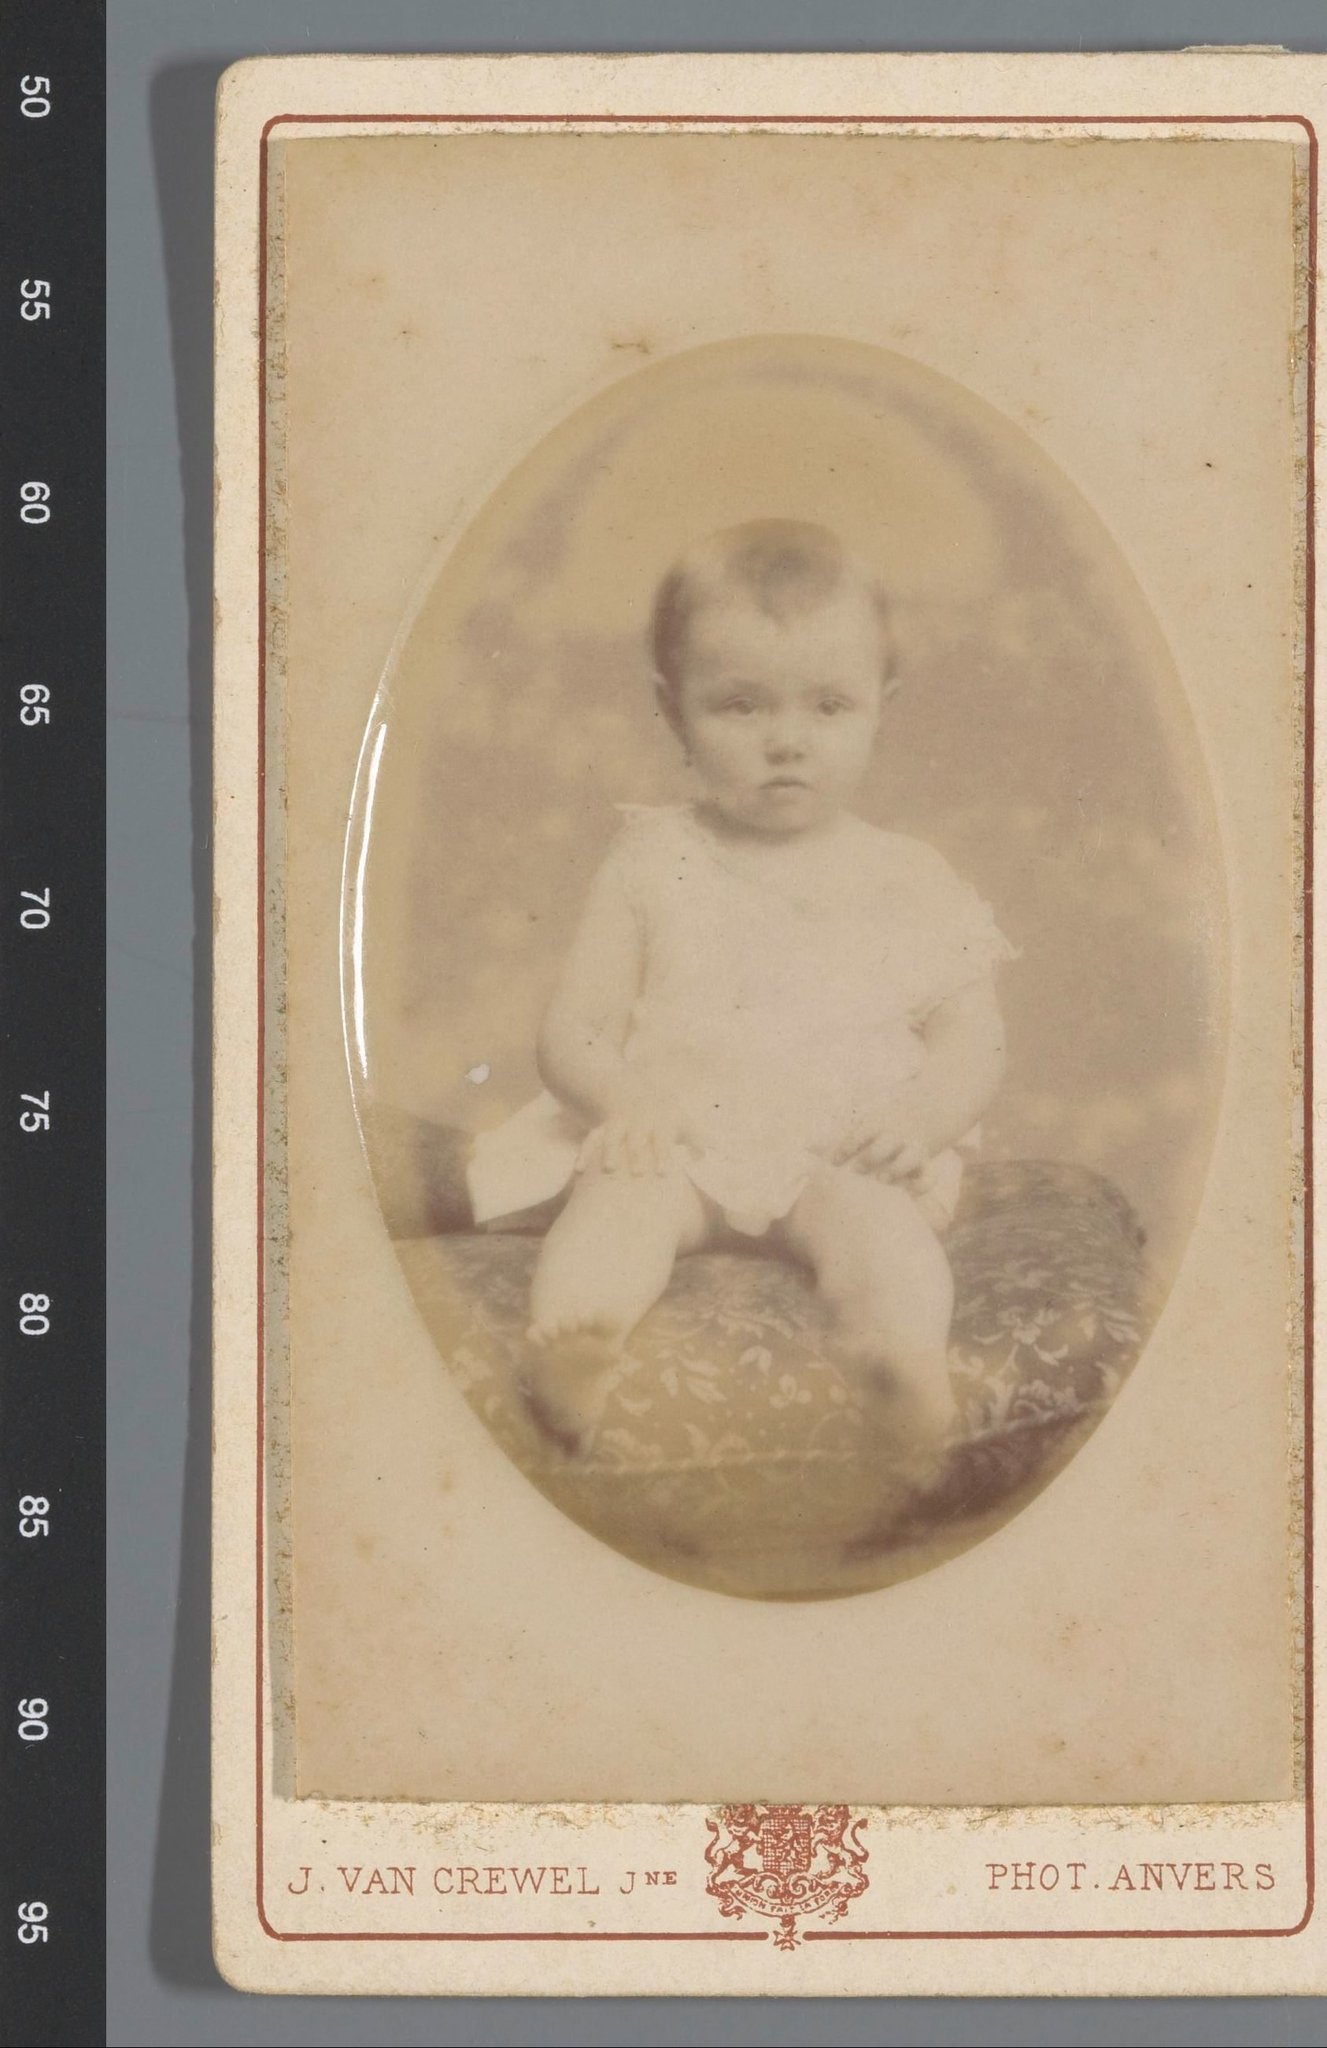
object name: photograph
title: Portret van een onbekend kind op een kussen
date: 1885-1900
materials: cardboard, celluloid, paper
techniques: albumen print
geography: antwerp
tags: child, anonymous historical person portrayed, antwerp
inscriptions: inscription: ‘Brévet d'Invention/ Médaille d'argent a/ l'Exposition Rubens 1881/ obtenue/ pour le procédé instantané./ Maison/ J. van Crewel Jeune/ Photographe (bréveté)/ 48. rue du Pélican, 48/ en face de la Gare/ Anvers/ Tous les Clichés sont conservés’, inscription: ‘J. van Crewel Jne Phot. Anvers’